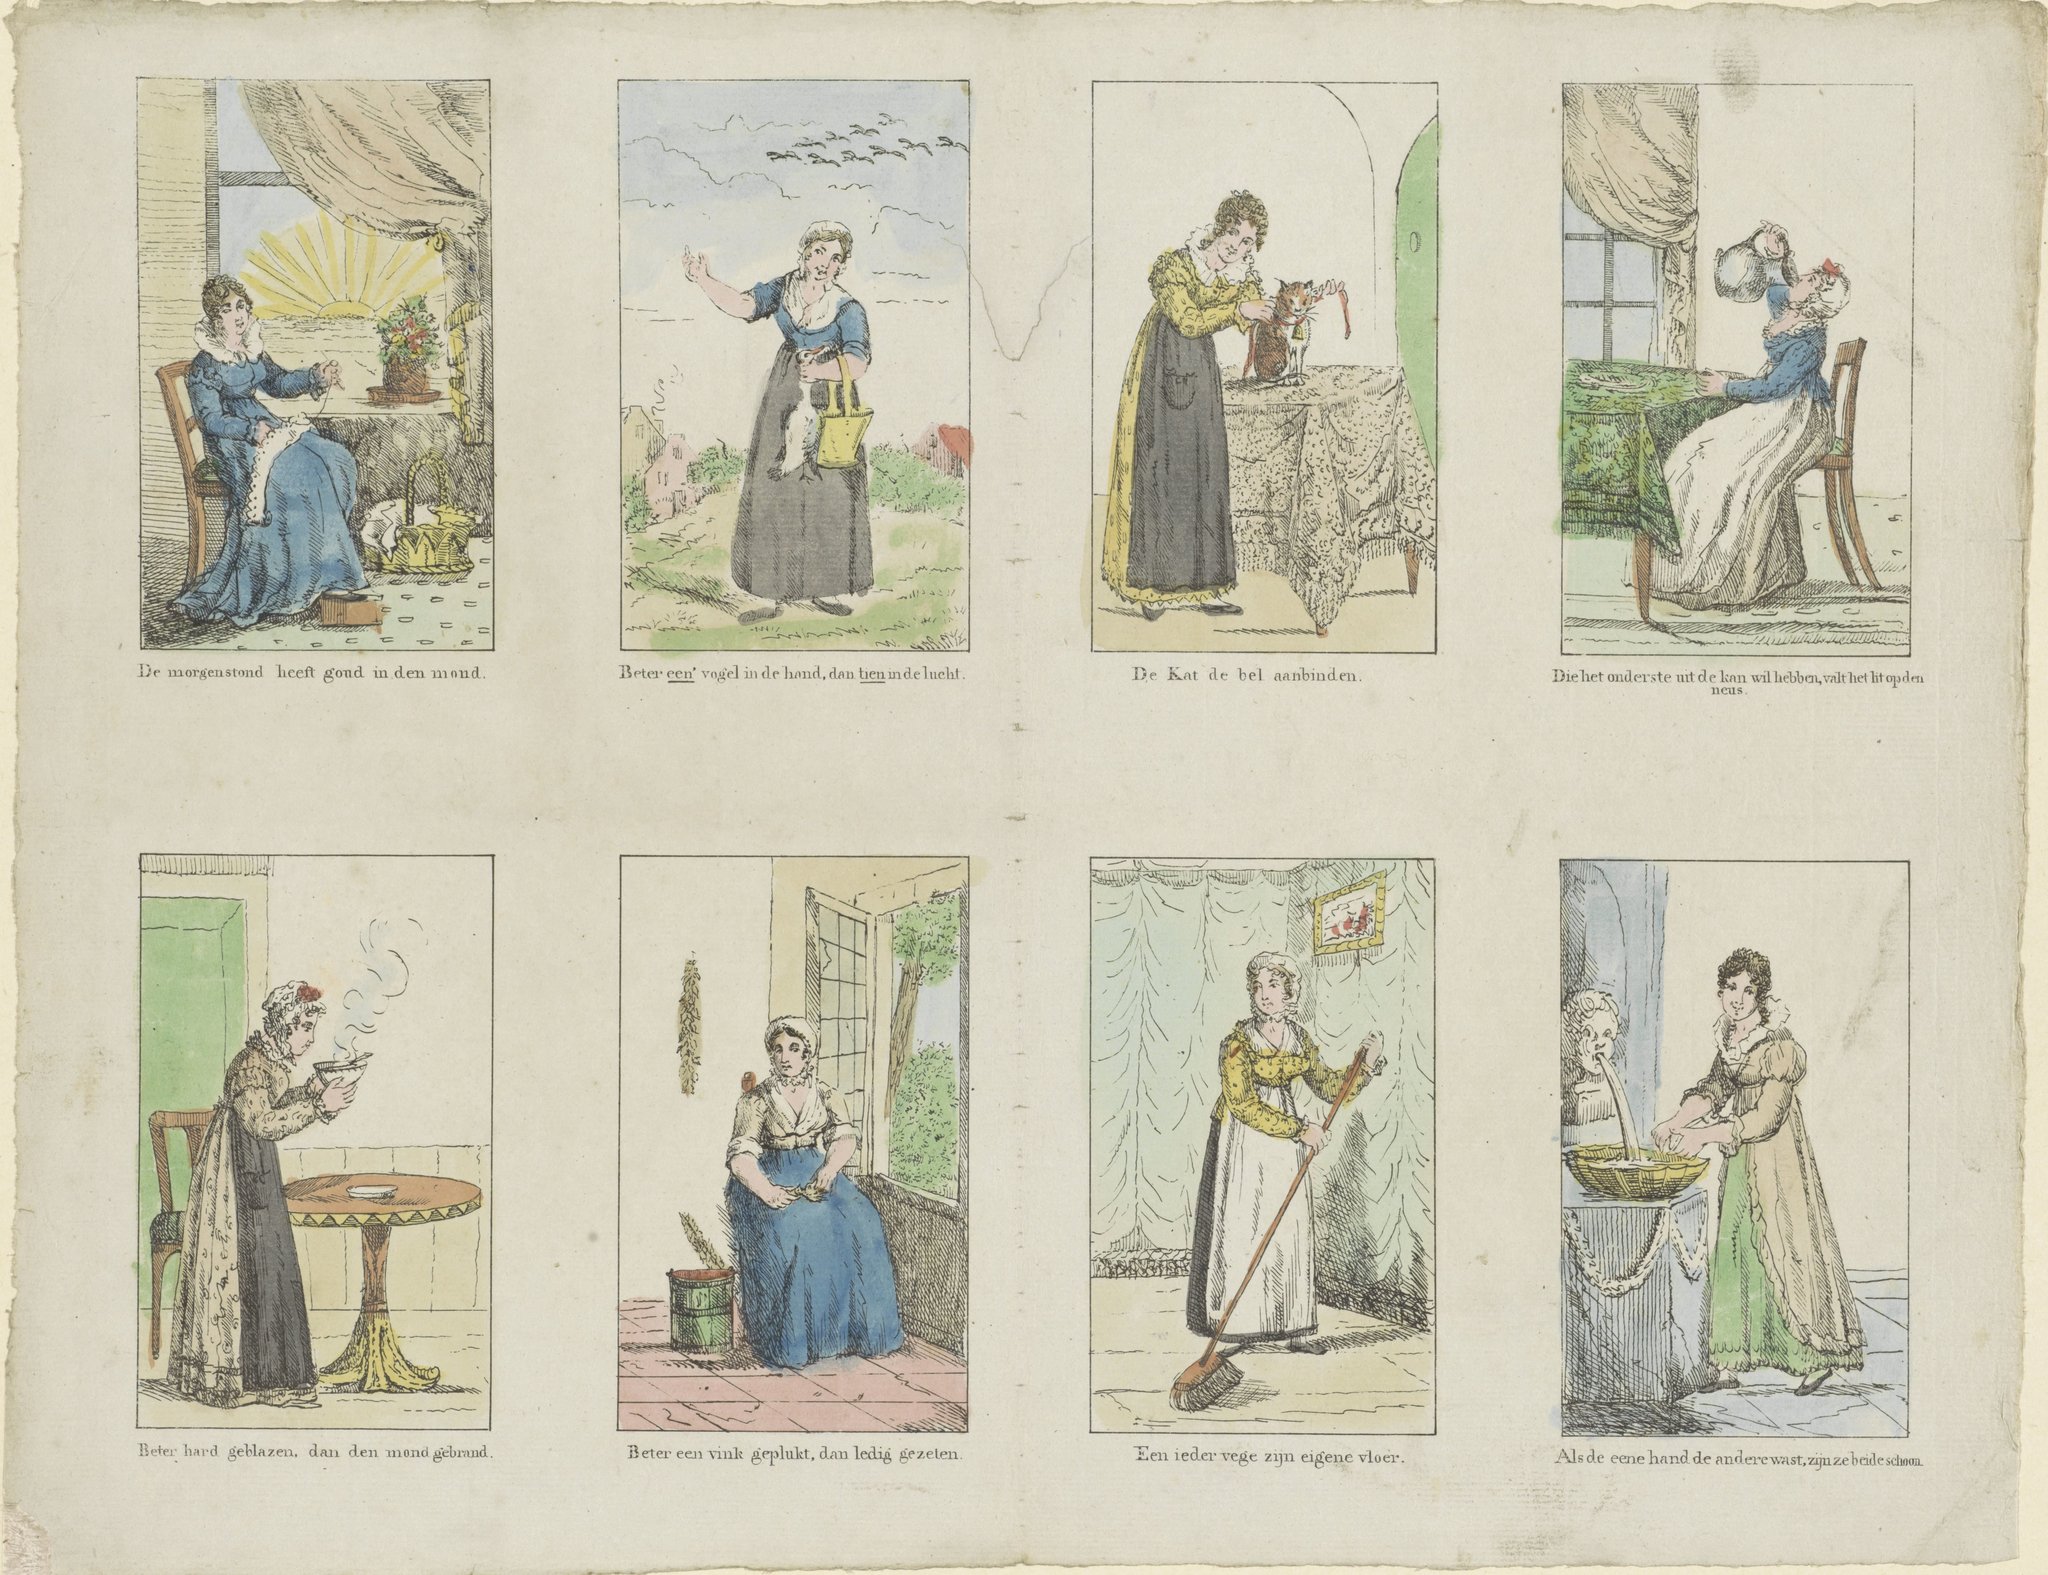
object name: print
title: Spreekwoorden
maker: Anonymous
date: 1825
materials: paper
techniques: colour, lithograph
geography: rotterdam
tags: proverbs, sayings, etc.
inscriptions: collector's mark: Lugt 2760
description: Blad met 8 verbeeldingen van spreekwoorden. Onder elke afbeelding een onderschrift.